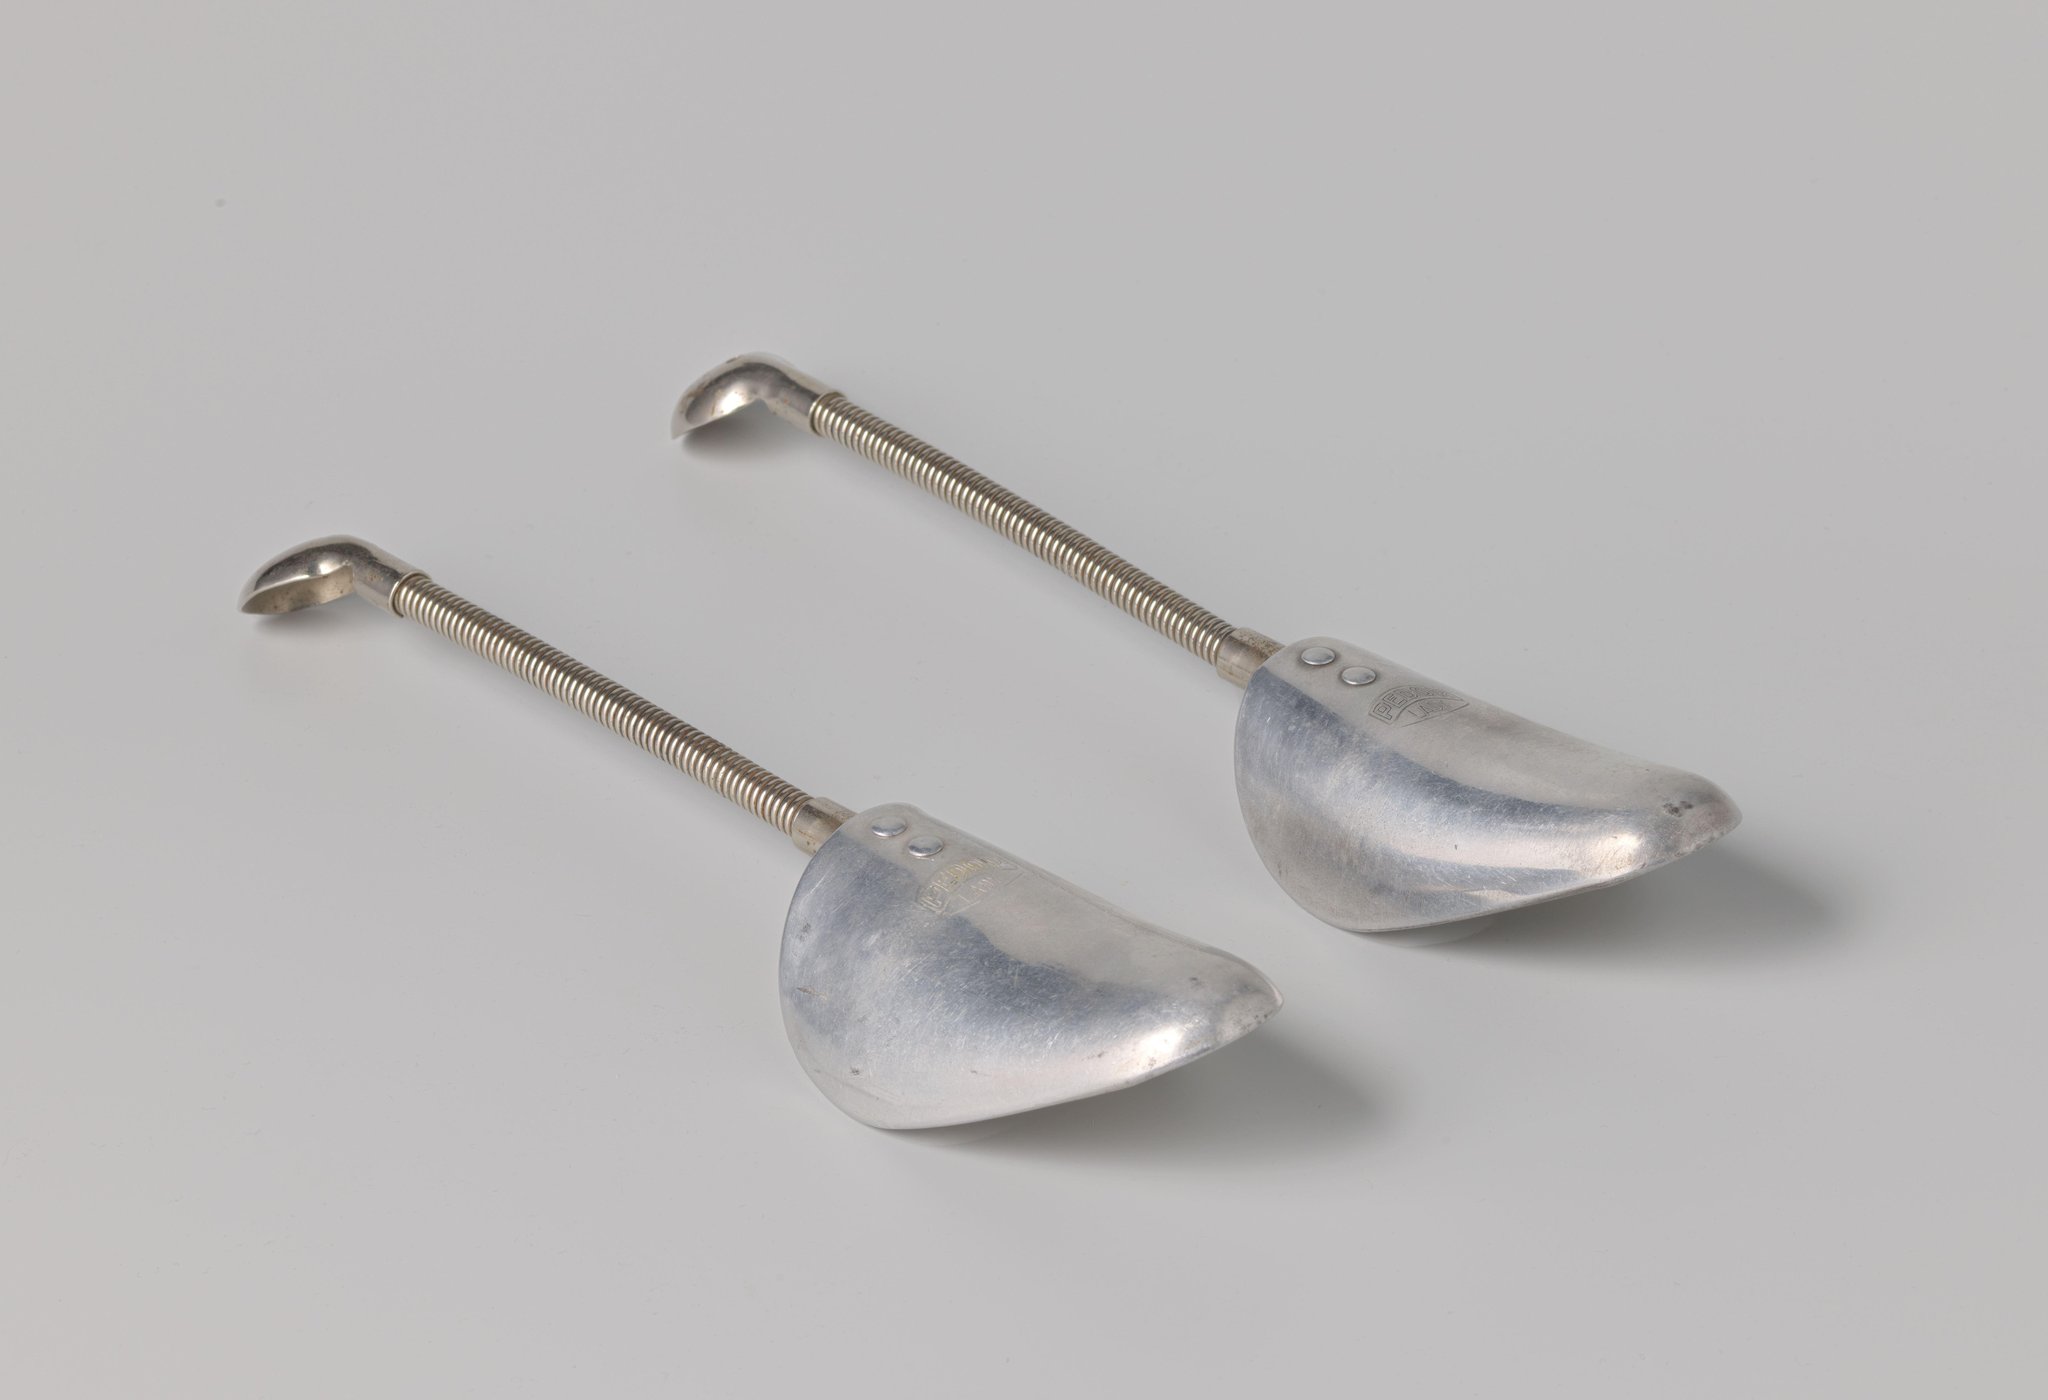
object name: shoe stretcher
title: Damesschoenspanner van metaal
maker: pedor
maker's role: schoenenfabrikant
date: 1940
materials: metal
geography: western europe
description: Rechterschoenspanner van metaal, op de wreef het merk pedor lady gestempeld.